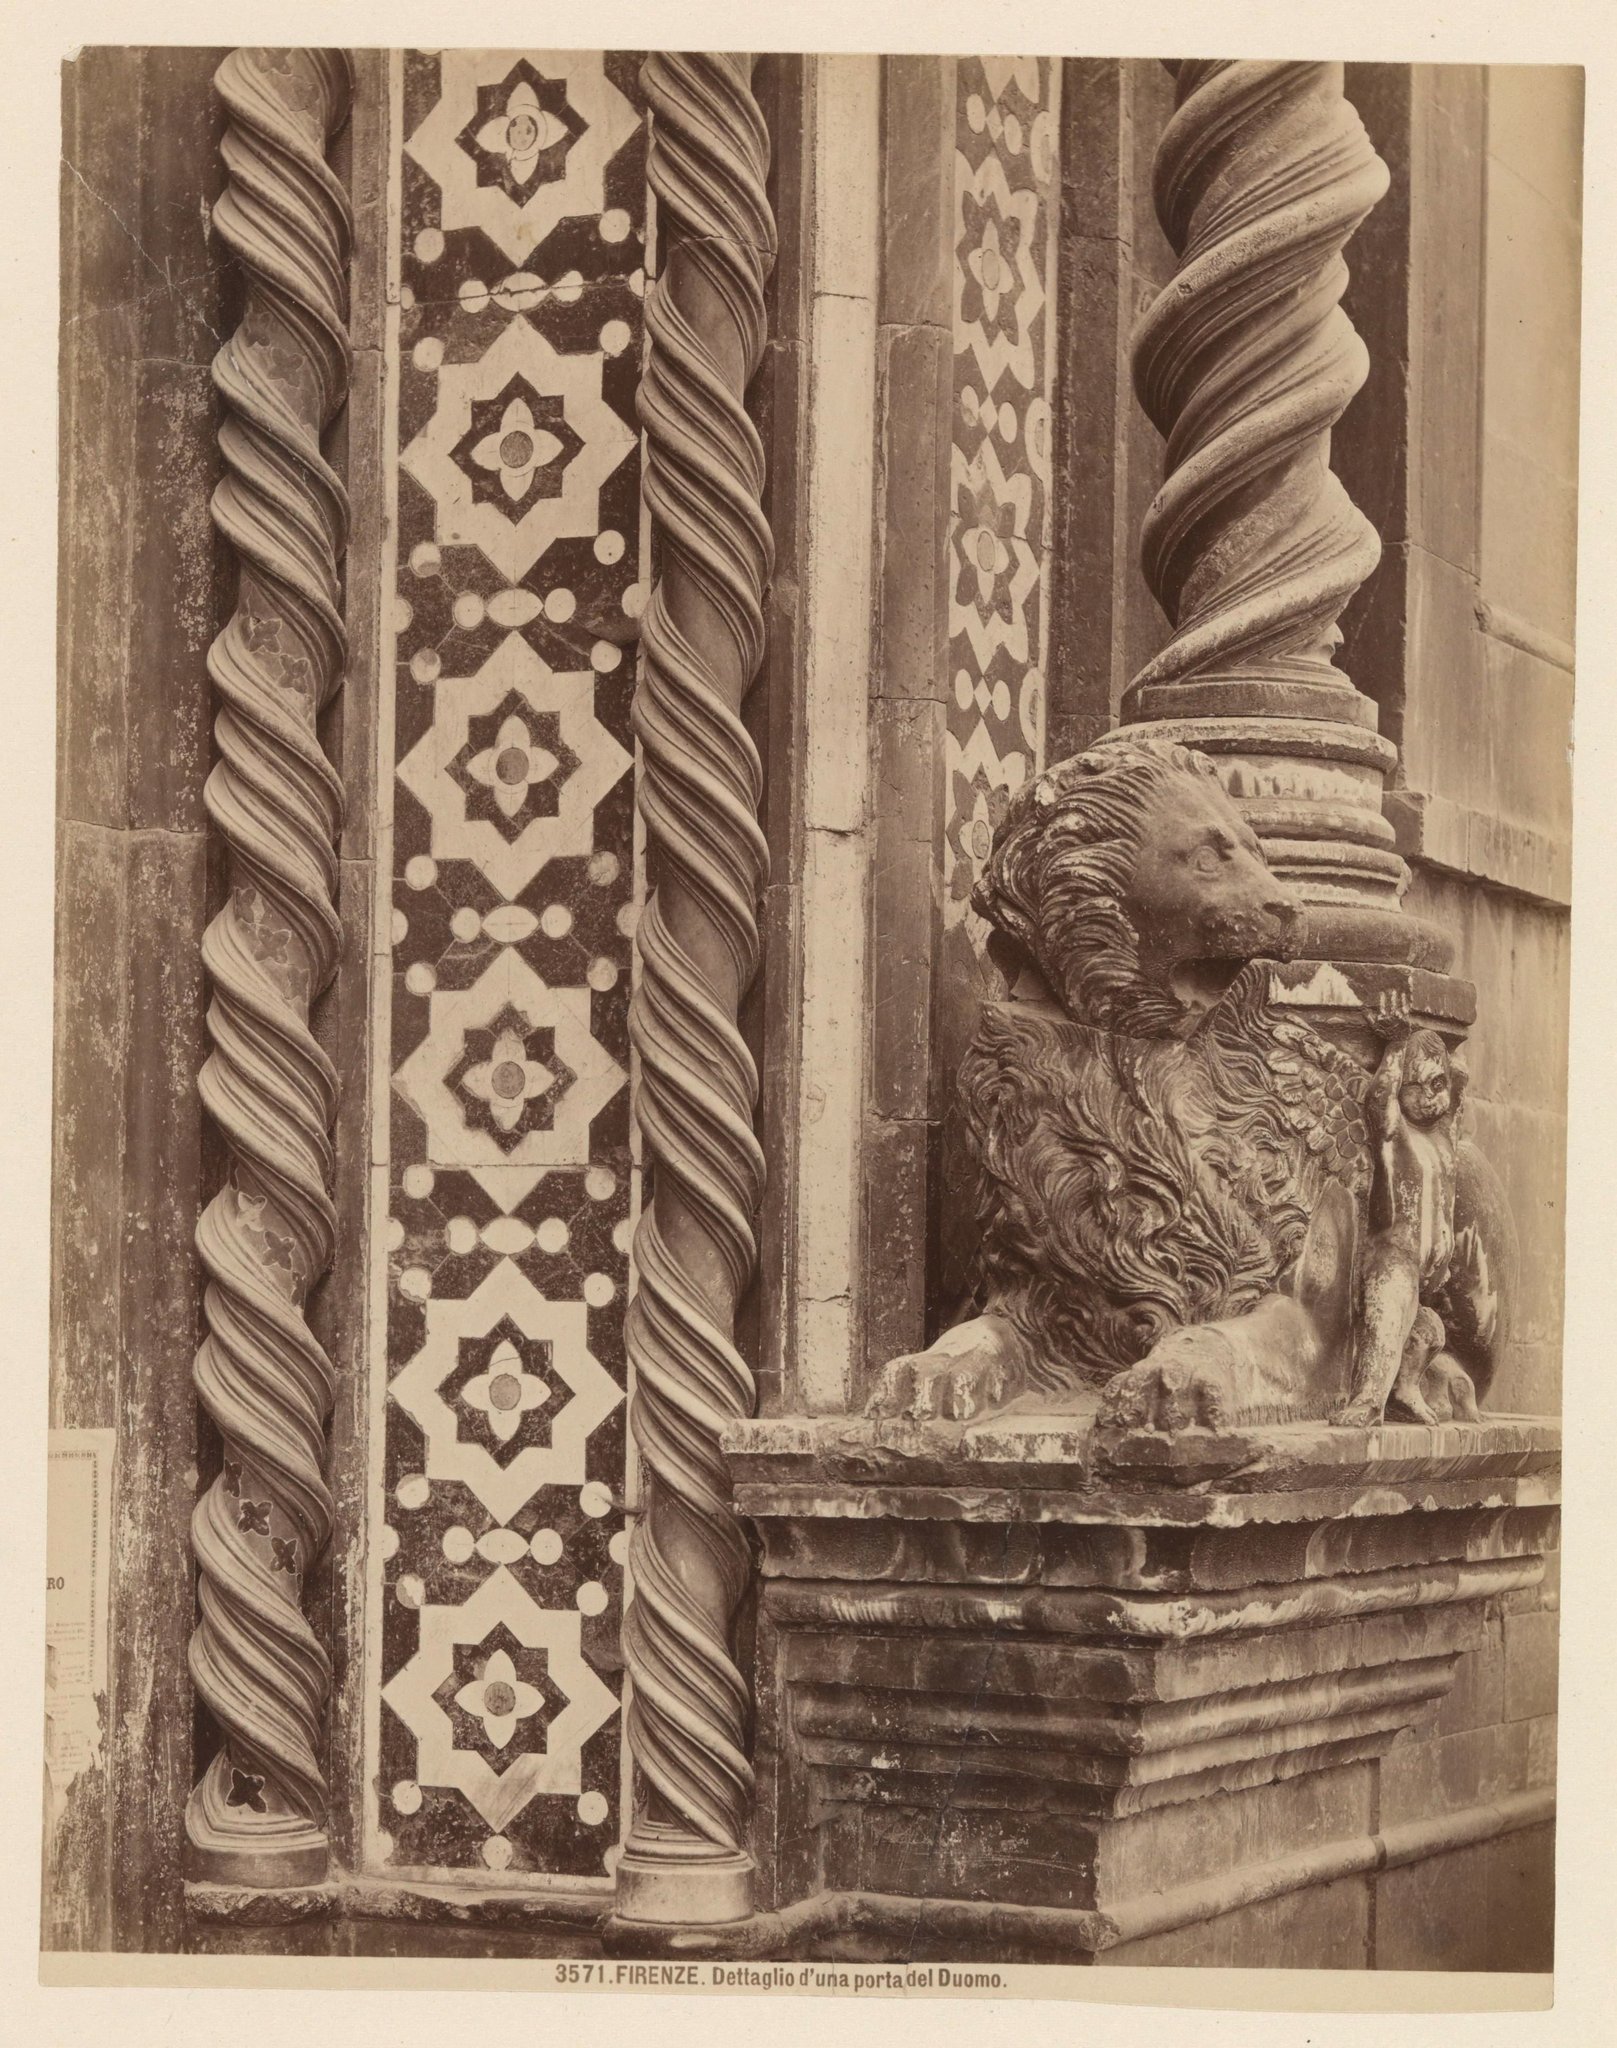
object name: photograph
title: Deel van een portaal van de Dom van Florence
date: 1870-1875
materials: cardboard, photographic support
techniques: albumen print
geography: florence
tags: parts of church exterior and annexes: portal, column, pillar ~ architecture, art (+ mosaic making), beasts of prey, predatory animals: lion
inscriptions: number: ‘3571.’, collector's mark: Lugt 3937